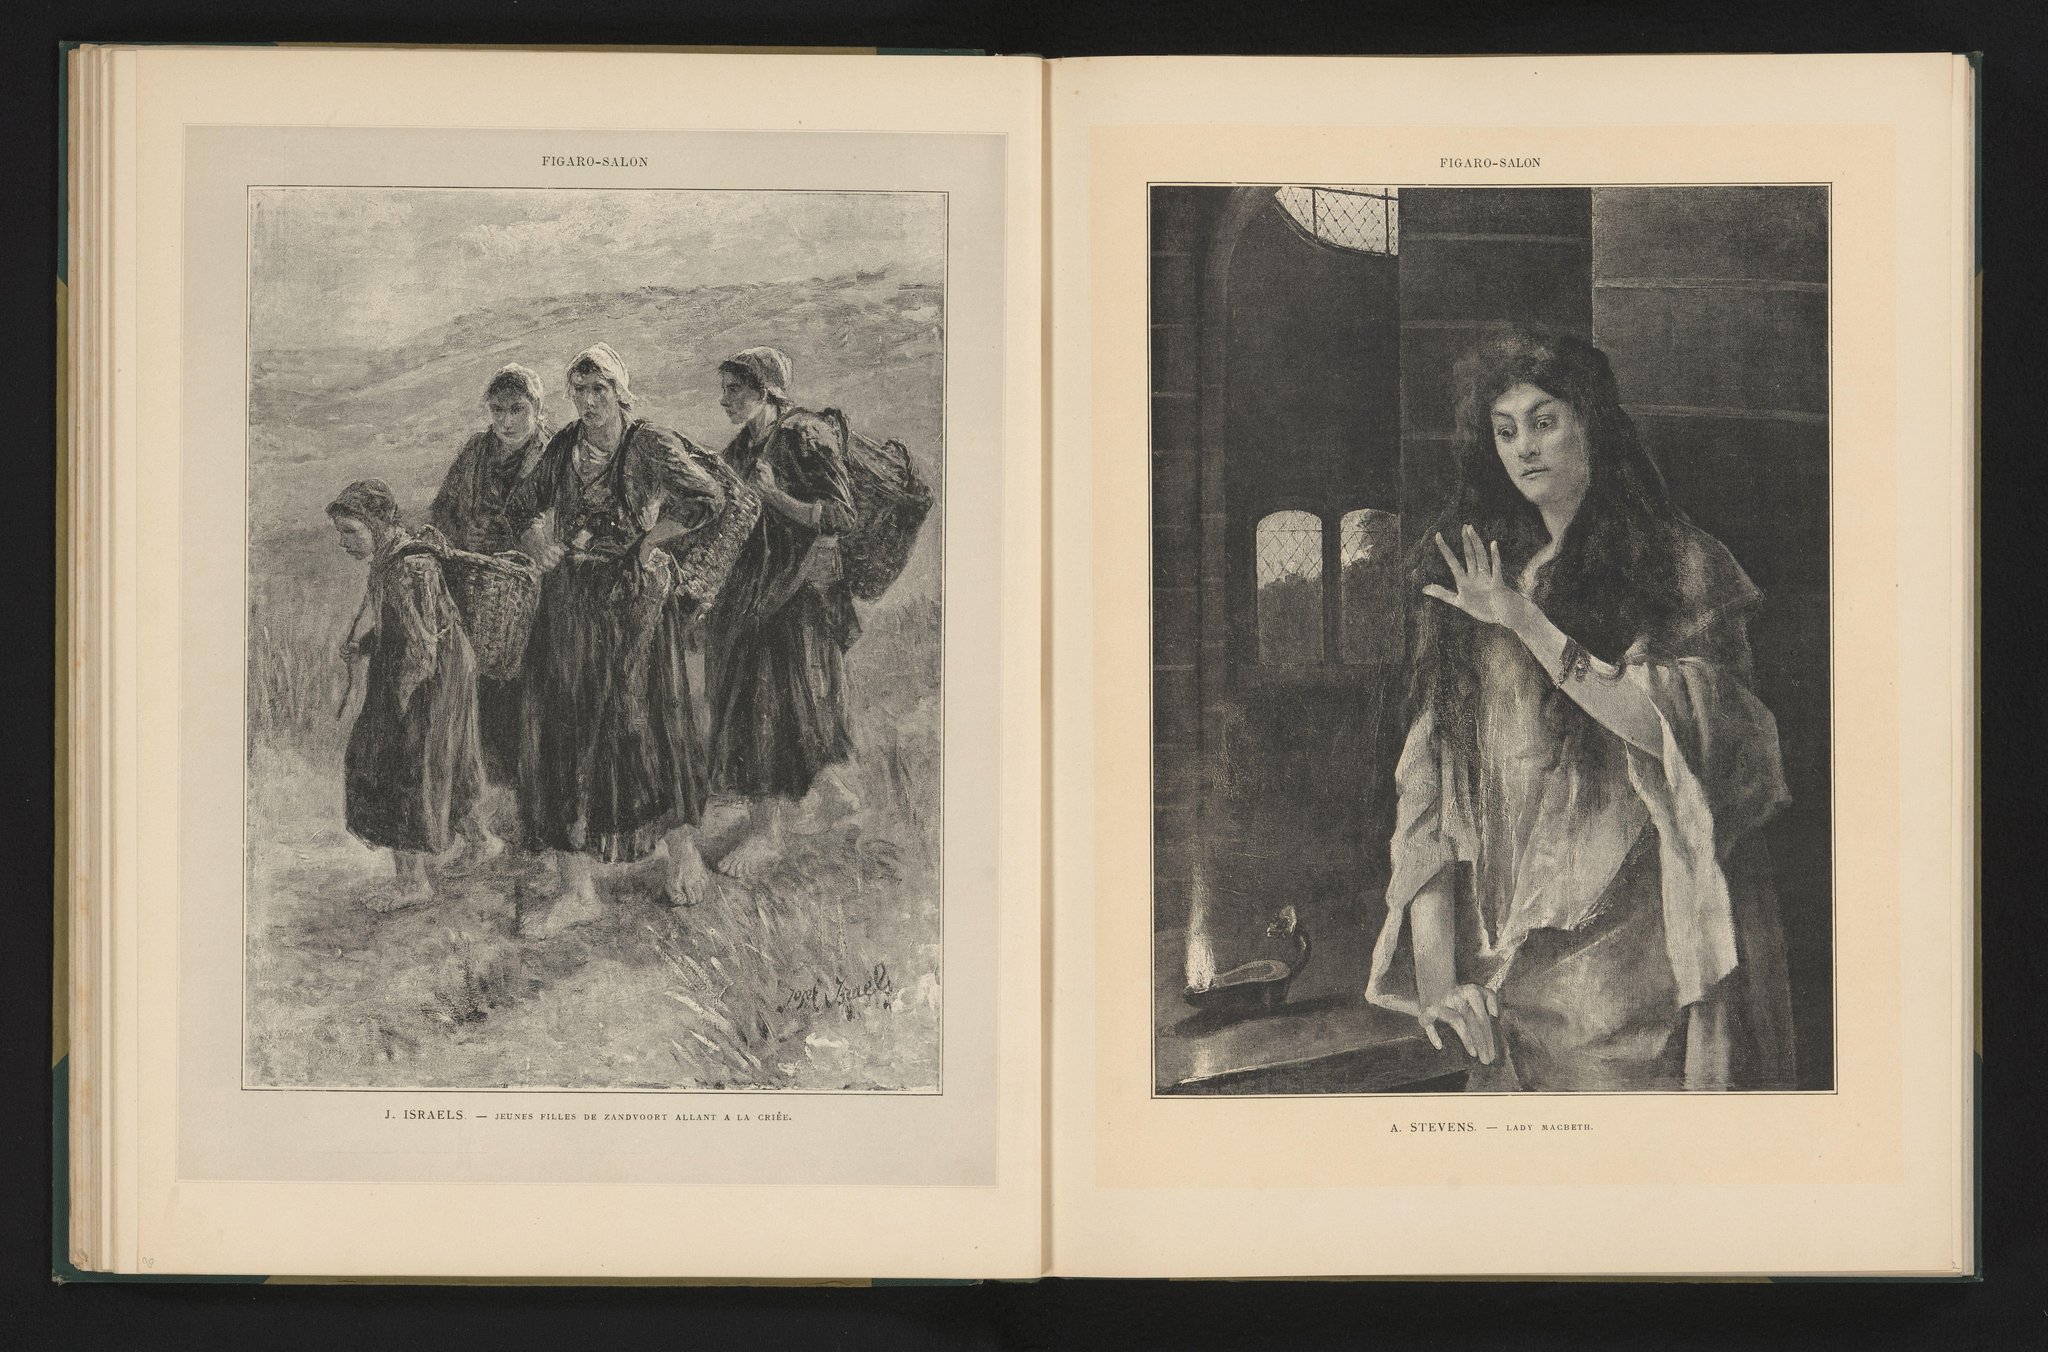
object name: reproduction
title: Reproductie van een schilderij van vier jongen vrouwen in de duinen te Zandvoort door Jozef Israëls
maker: Anonymous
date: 1885-1901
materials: paper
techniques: autotype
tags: dunes (sea not visible); in the dunes (+ landscape with figures, staffage)